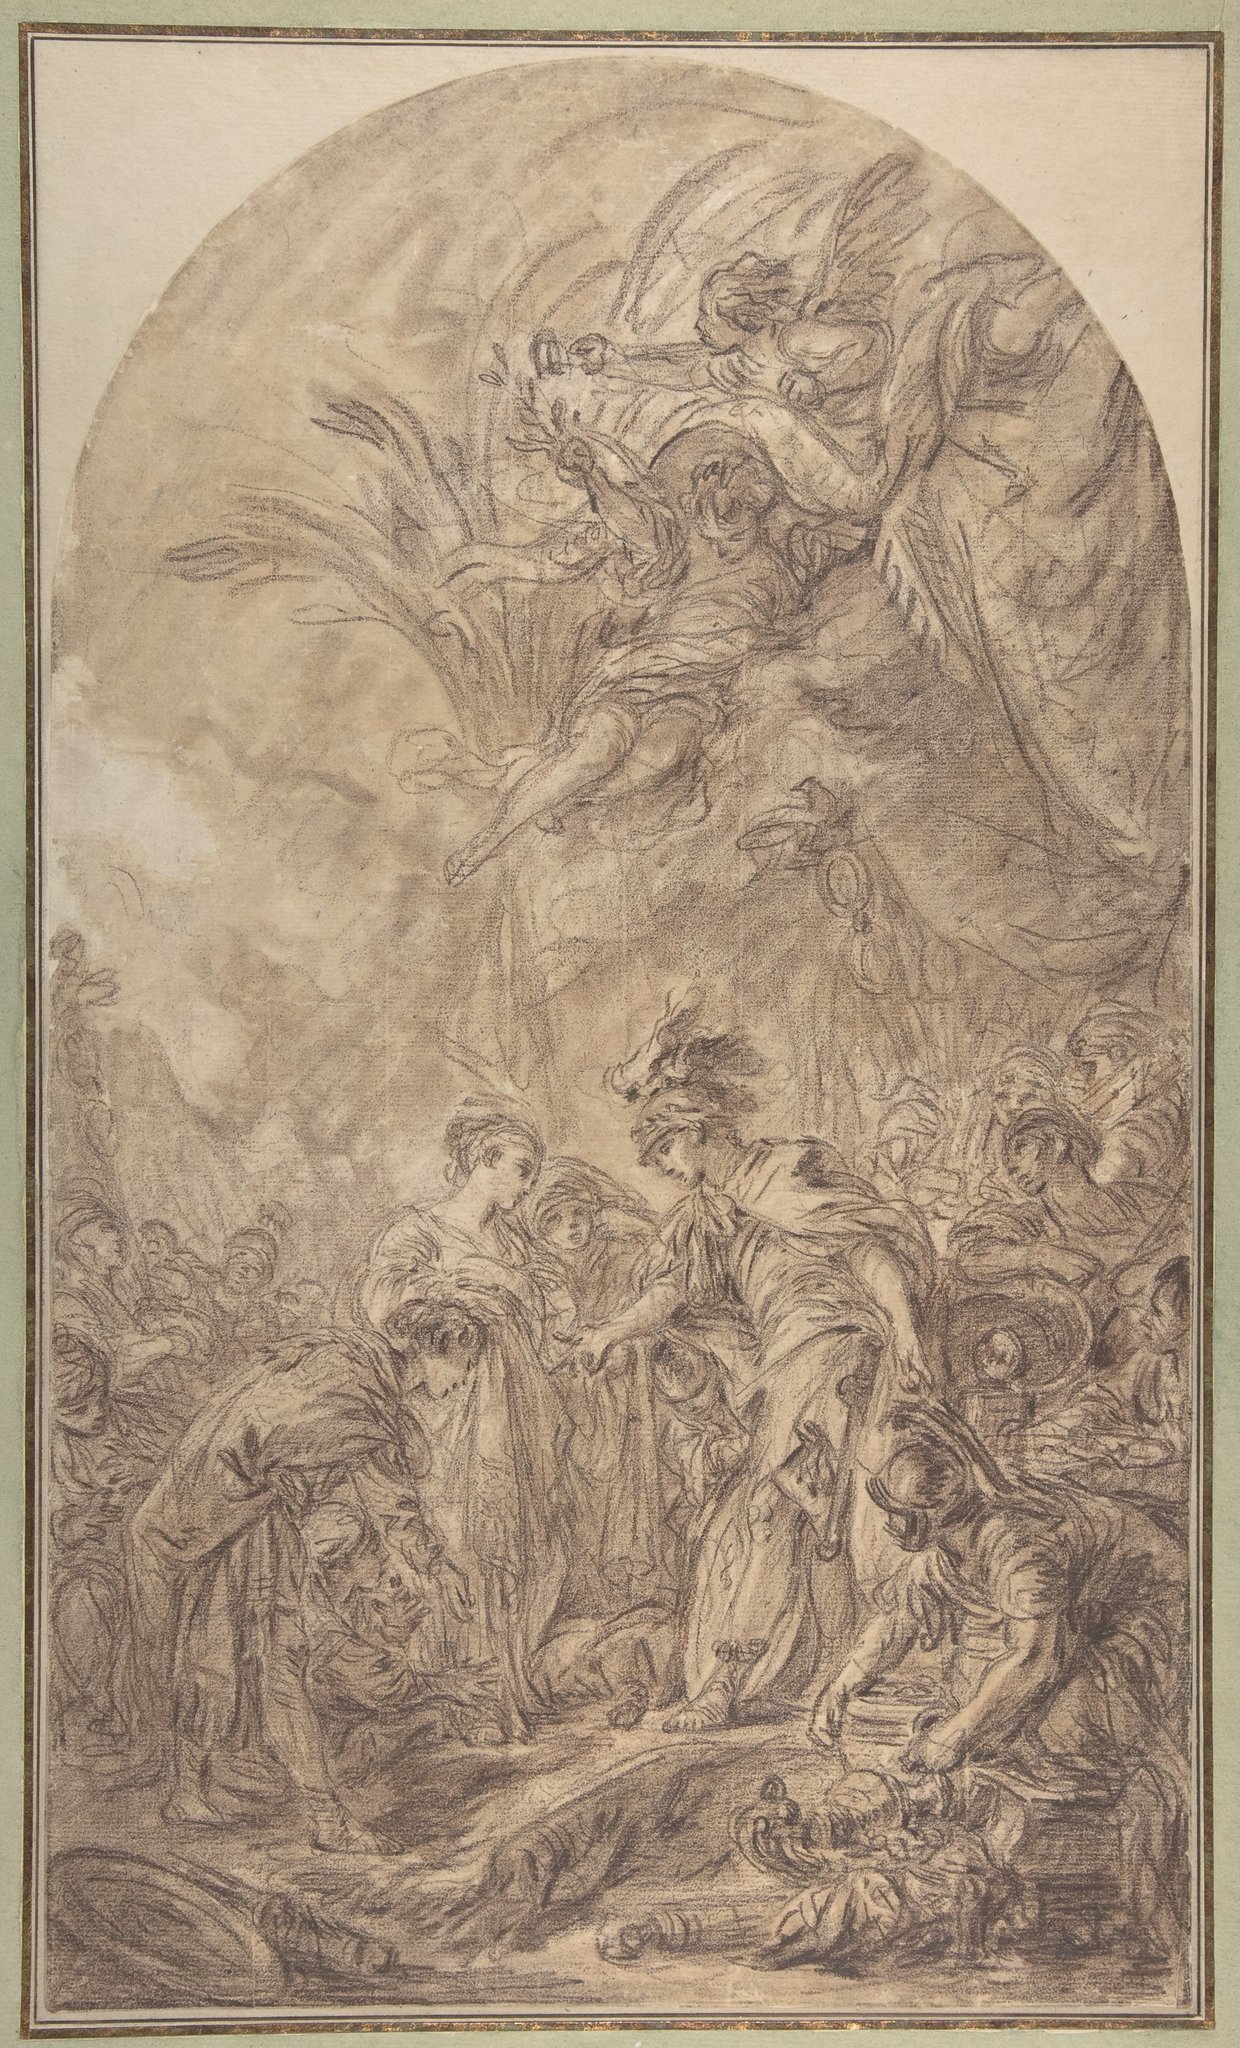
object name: drawing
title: The Continence of Scipio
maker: françois boucher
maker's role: artist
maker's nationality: french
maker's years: 1703-1770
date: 1700-1770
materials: chalk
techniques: brush, wash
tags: soldiers,men,women,angels